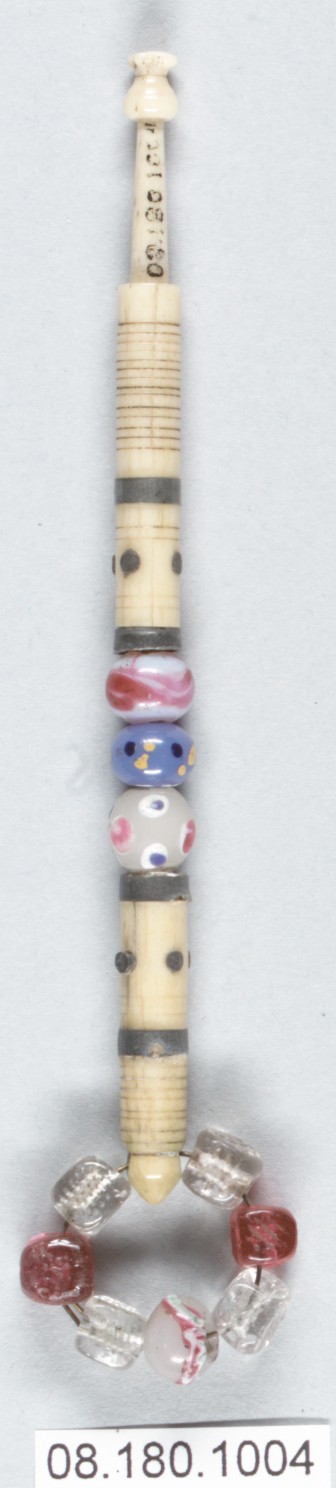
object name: bobbin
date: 1801-1900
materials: bone, metal